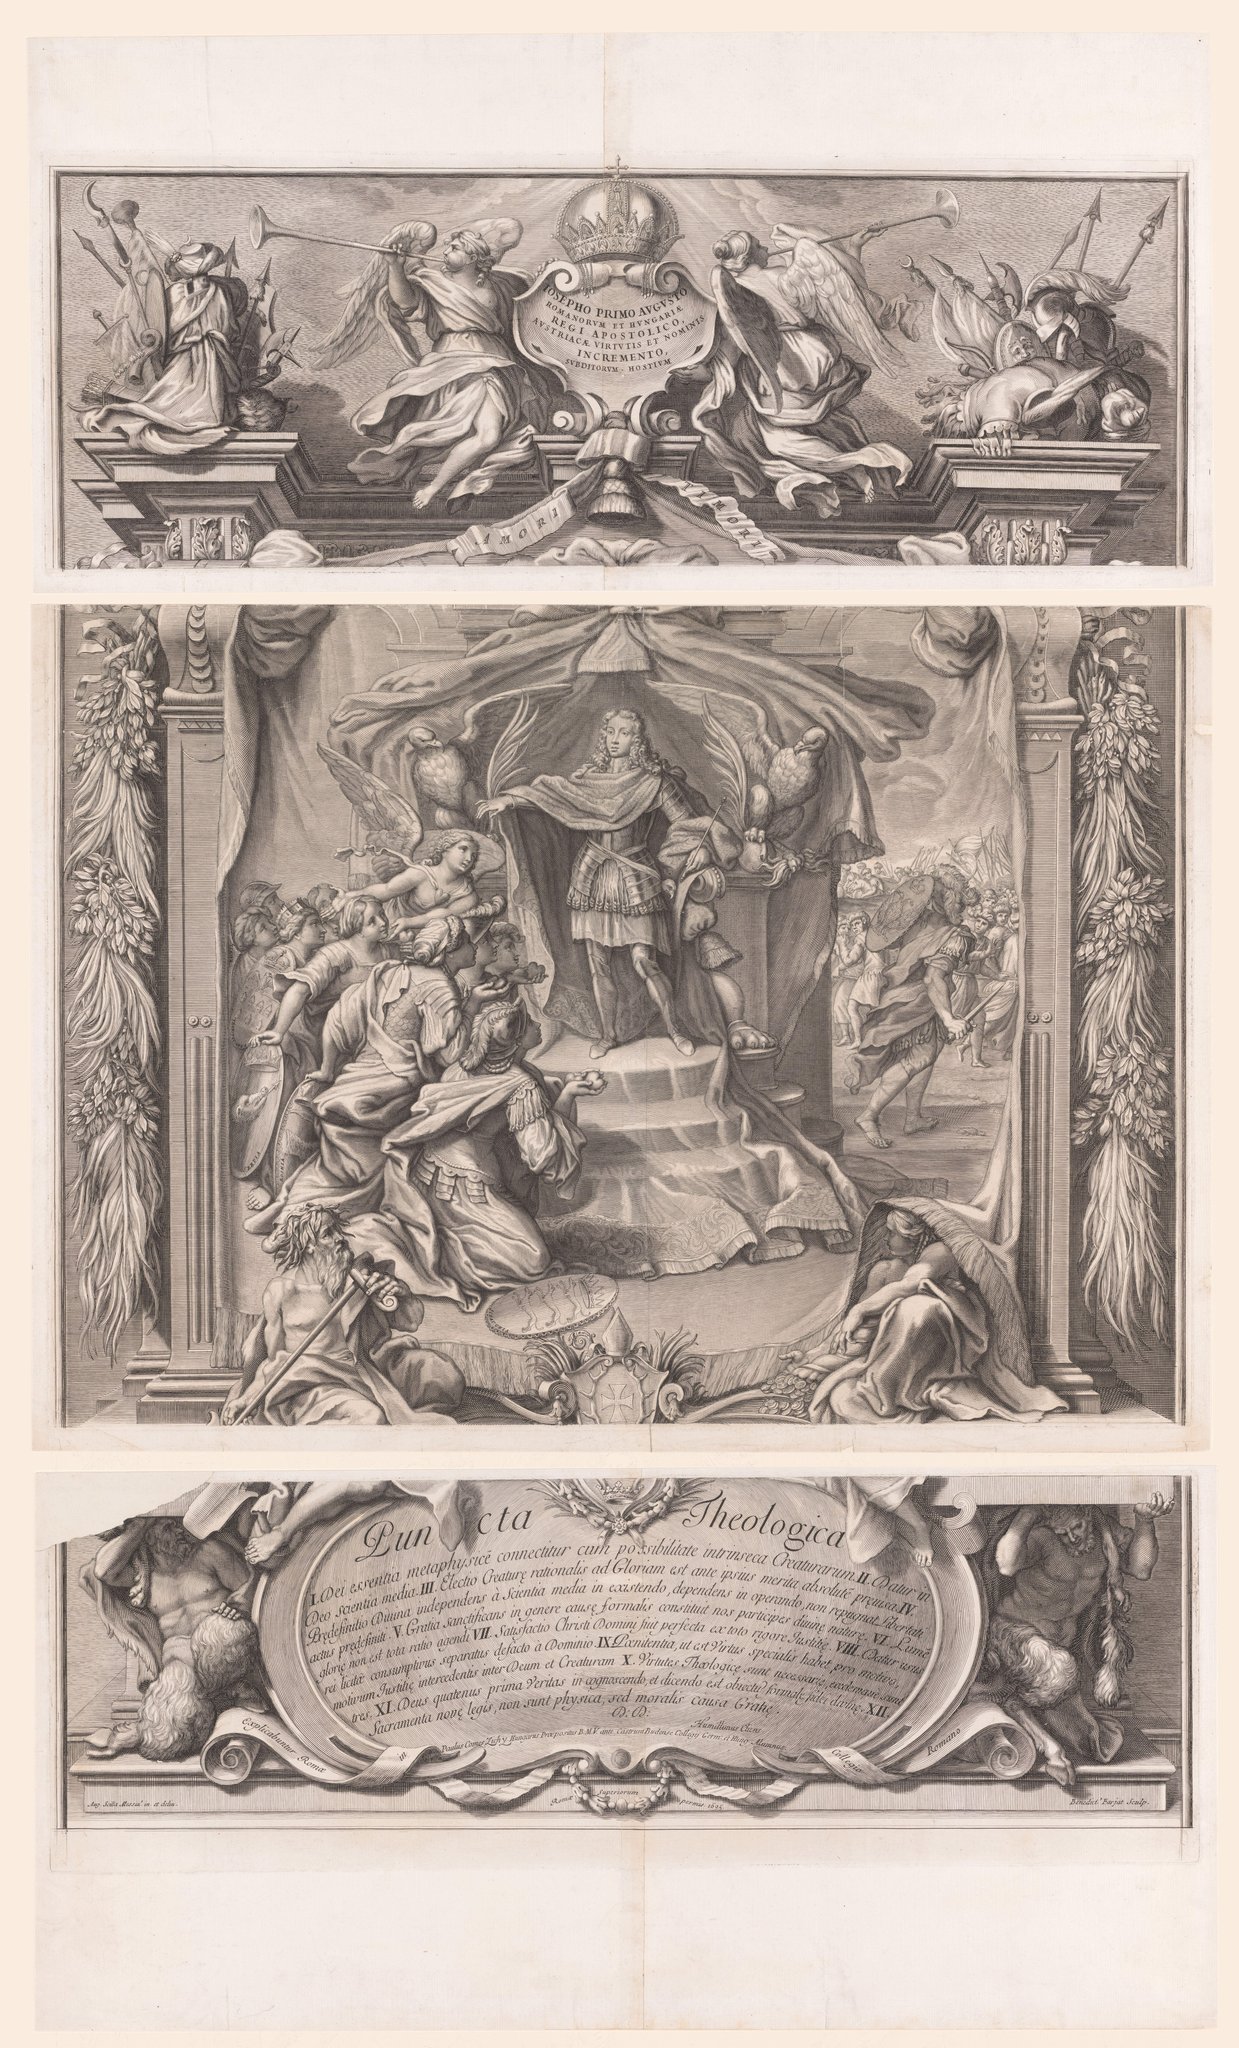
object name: print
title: These van Paul, graaf van Zicky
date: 1695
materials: paper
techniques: engraving, etching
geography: rome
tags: doctoral thesis, ornament ~ cartouche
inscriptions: collector's mark: Lugt 240, collector's mark: Lugt 2165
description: Dit object is omwille van een betere presentatie virtueel samengevoegd, maar bestaat fysiek uit losse onderdelen.